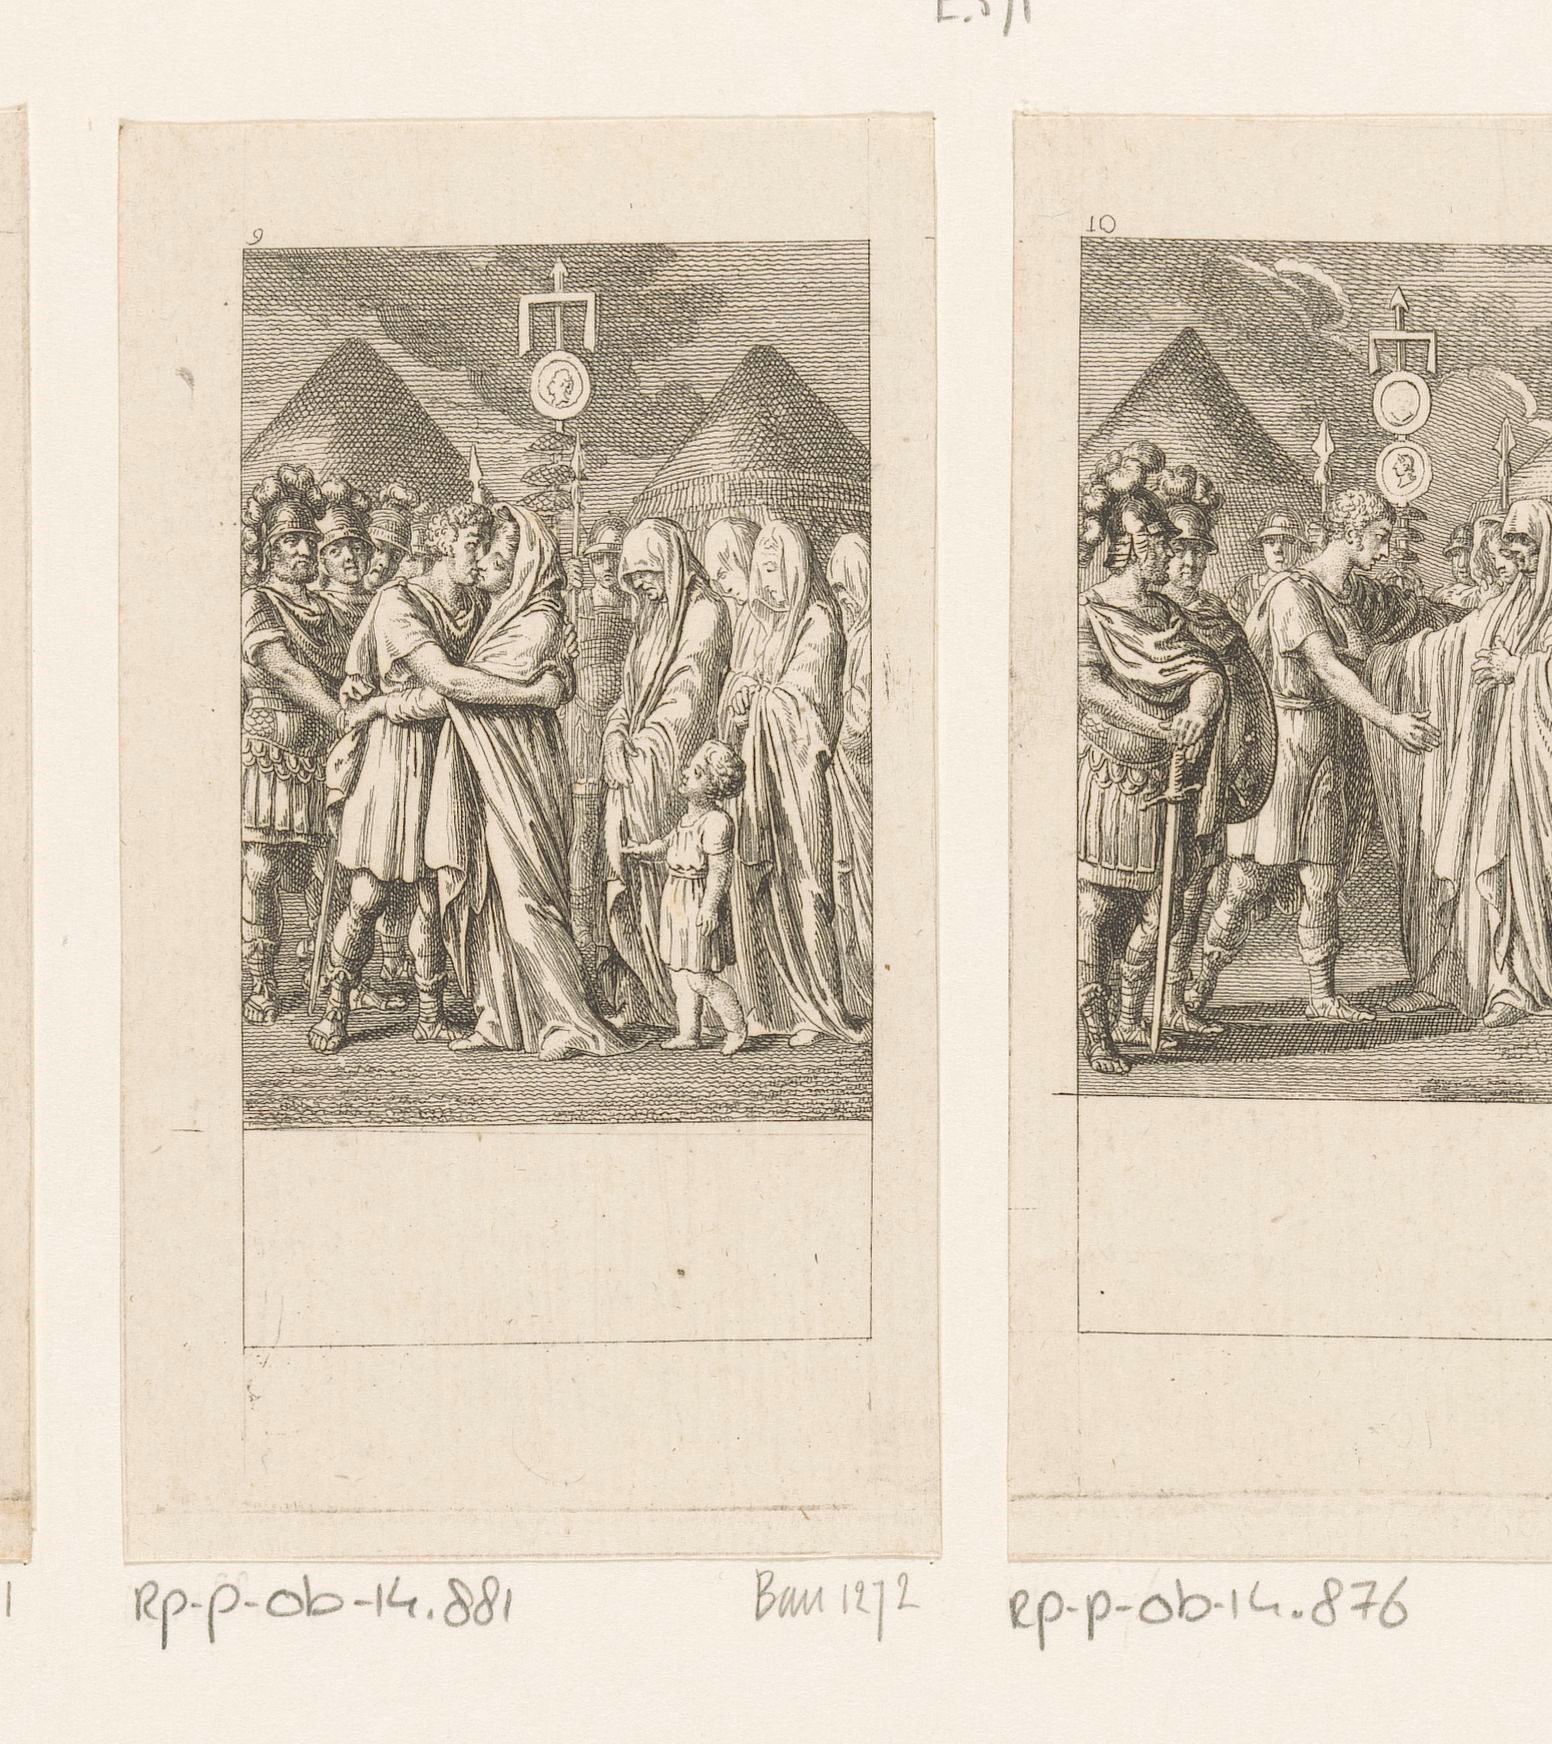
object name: print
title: Coriolan omarmt en kust zijn vrouw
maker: daniel nikolaus chodowiecki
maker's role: draughtsman, print maker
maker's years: 1726-1801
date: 1786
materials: paper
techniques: etching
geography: berlin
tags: william shakespeare, prayer or religious service before battle, (story of) coriolanus, literature, (lovers) embracing each other, 'symplegma', roman religion (including etruscan religion)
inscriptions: collector's mark: Lugt 2228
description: Vervaardigd voor William Shakespeares 'Coriolan'. Latere staat gebruikt voor: Königl. Grosbrit. Genealogischer Kalender auf das Jahr 1787. Lauenburg: J. G. Berenberg, [1786].